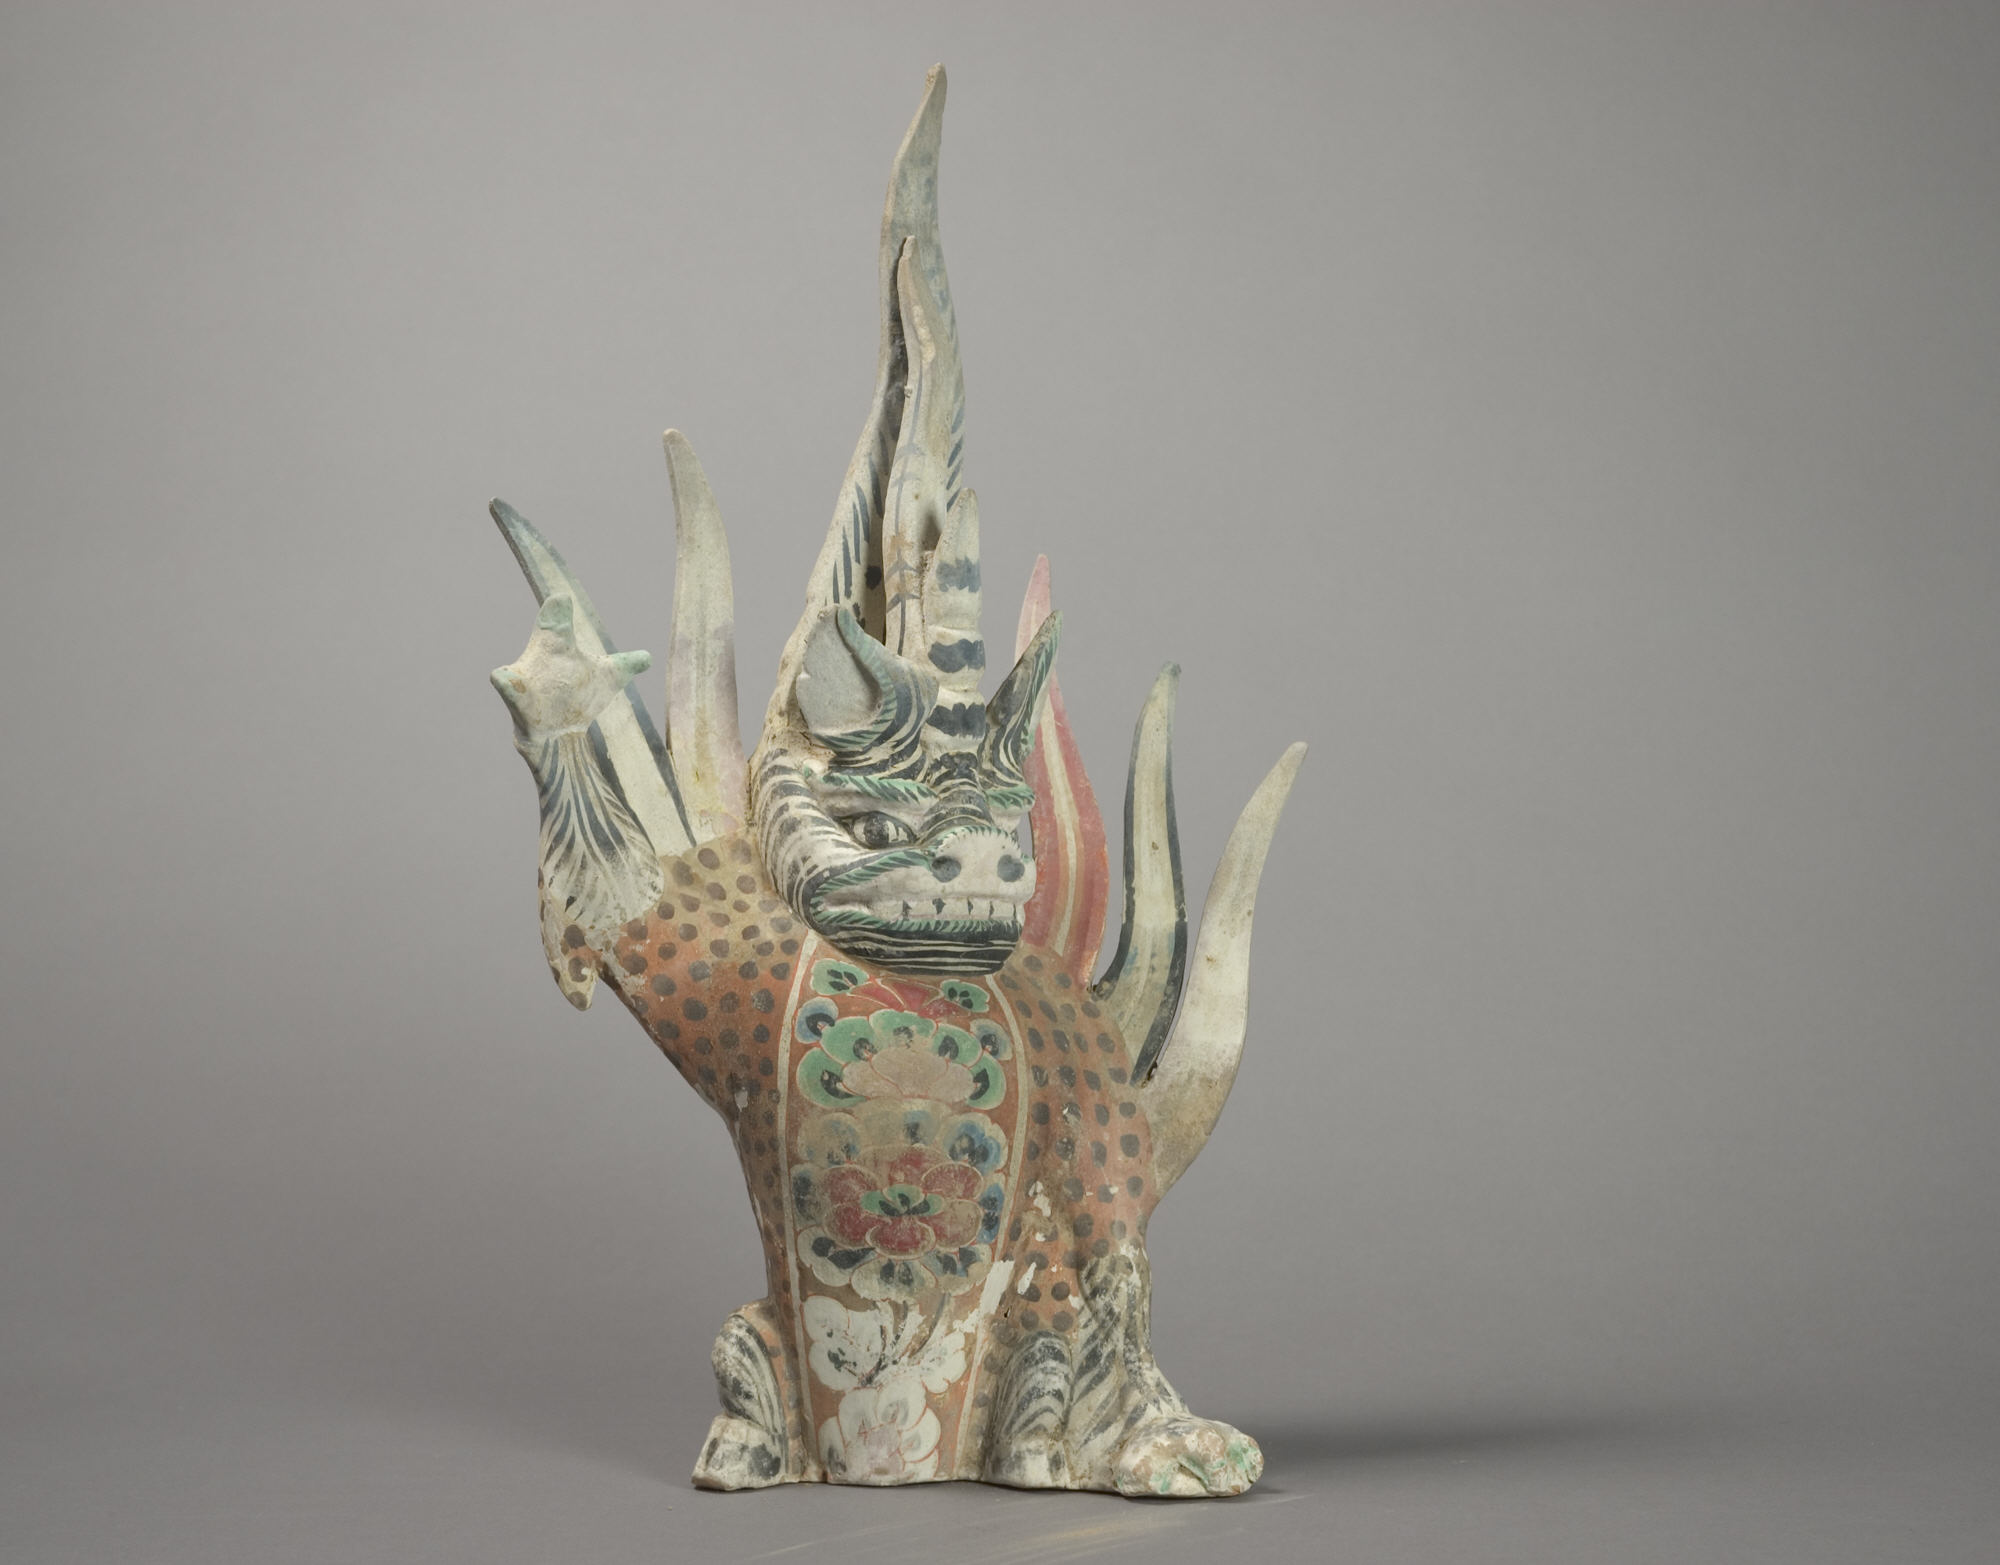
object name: tomb guardian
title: Tomb guardian beast (Zhenmushou)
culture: chinese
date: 667-733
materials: earthenware, pigment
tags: mythical creatures